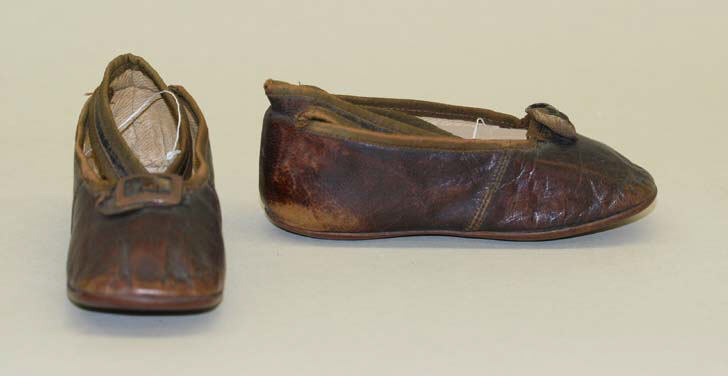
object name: shoe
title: Shoes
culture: american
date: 1834-1866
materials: leather, metal